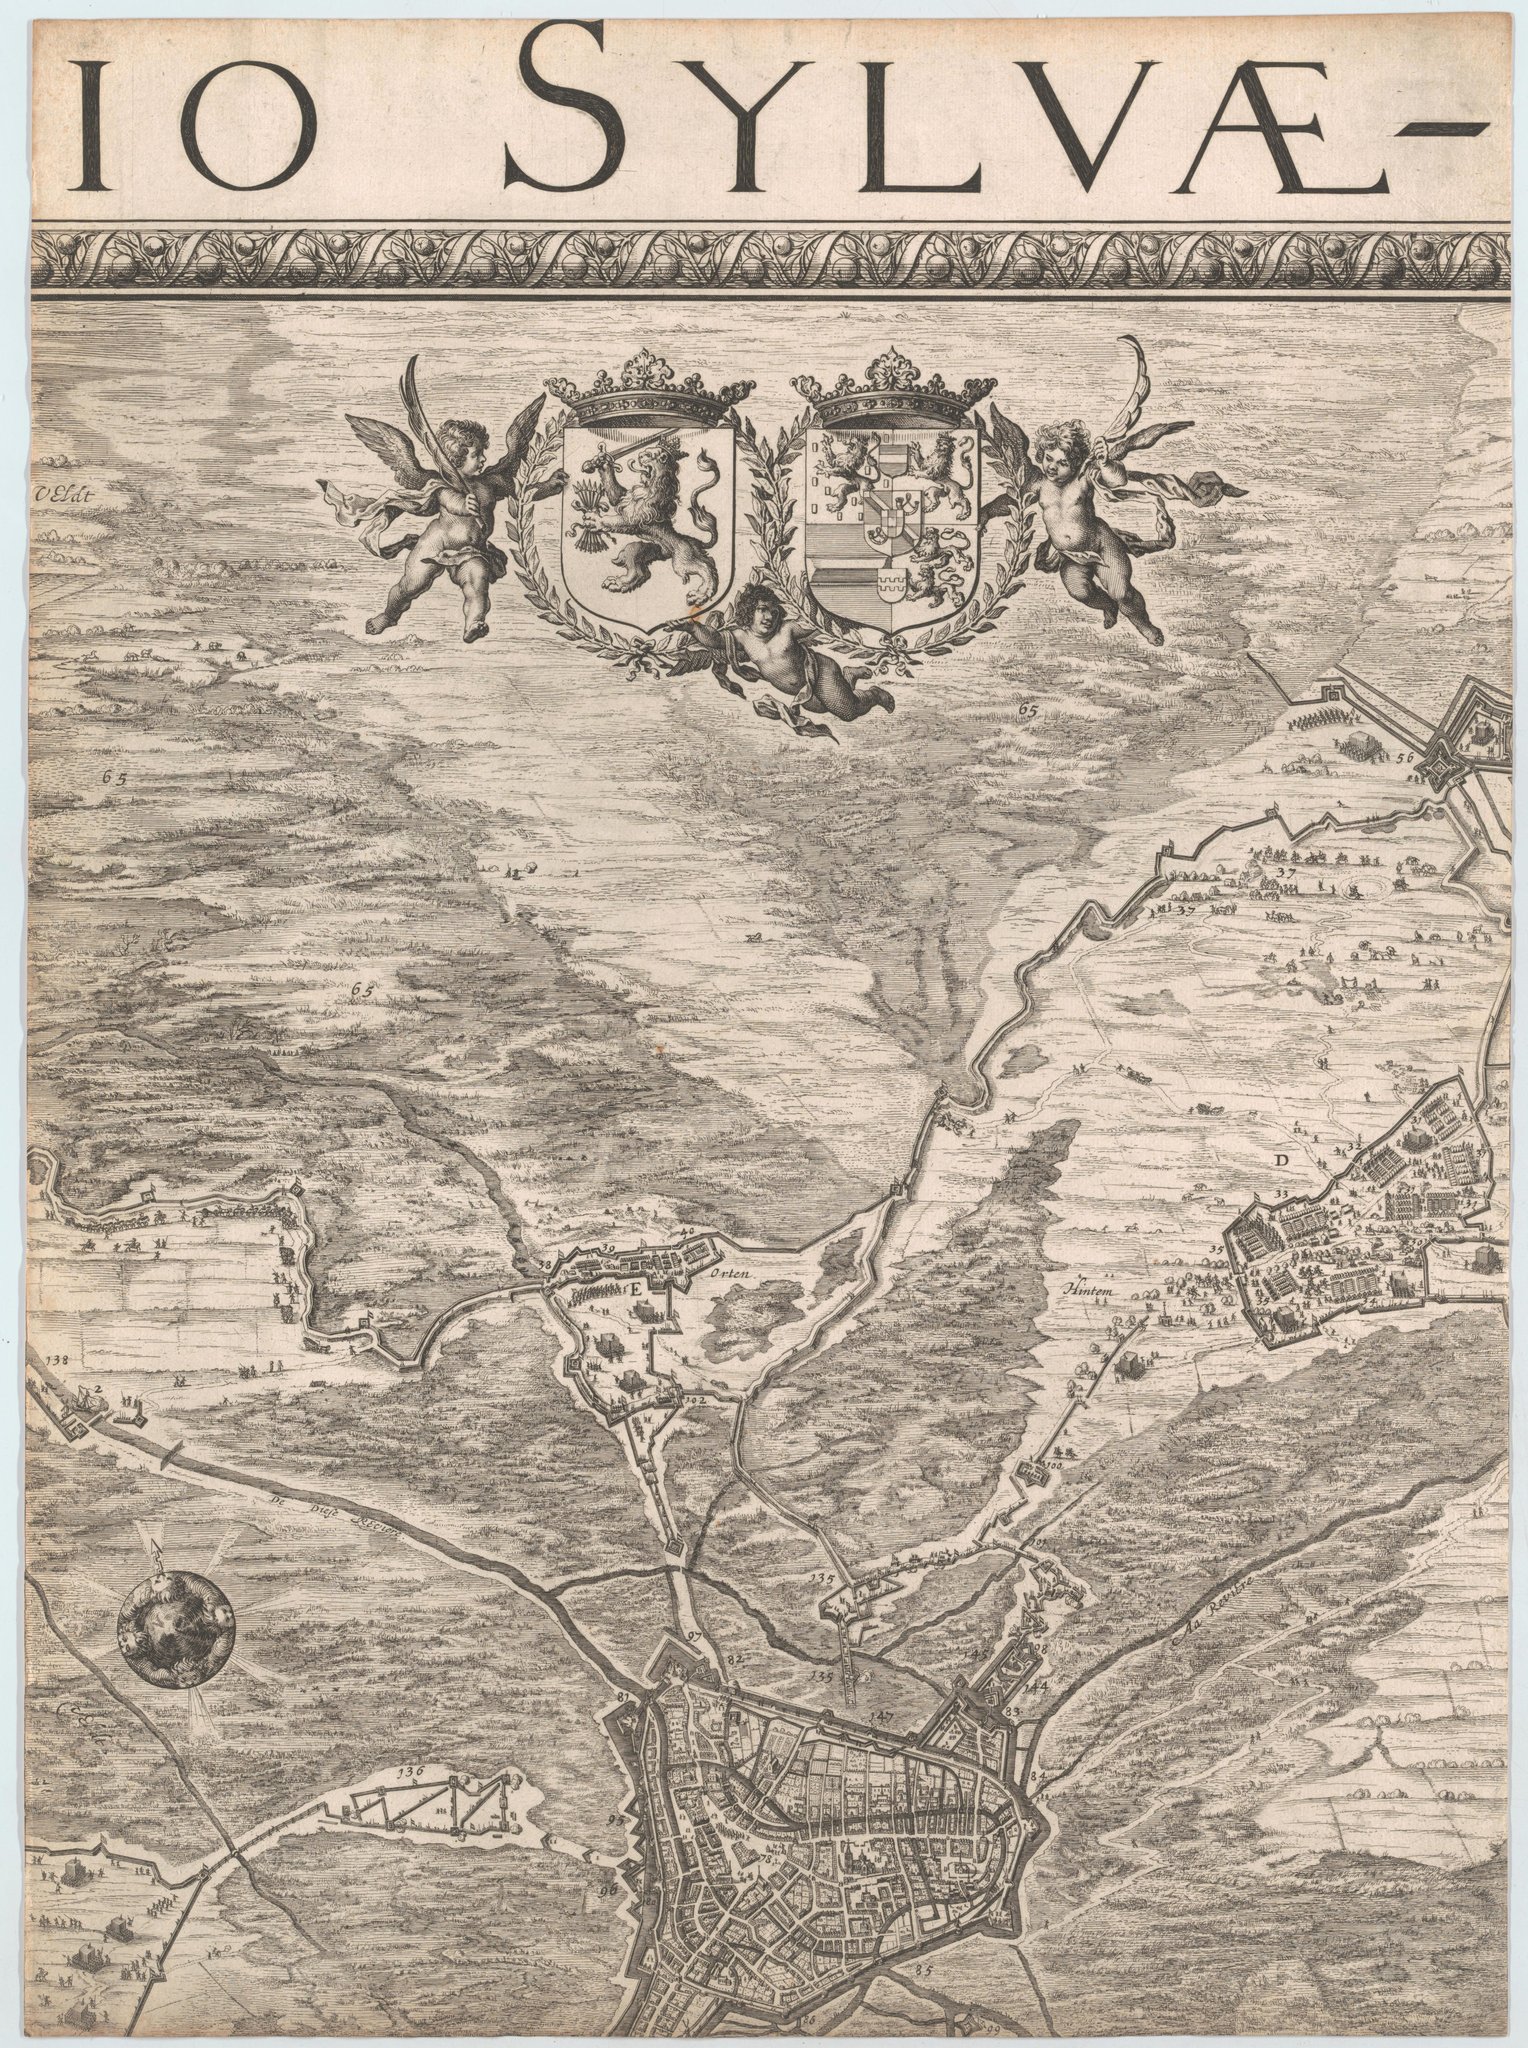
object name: print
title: Grote kaart van het beleg van Den Bosch door Frederik Hendrik (blad middenboven), 1629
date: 1629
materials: paper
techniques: etching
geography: the hague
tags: the hague, frederick henry (prince of orange), maps of separate countries or regions, siege, position war, den bosch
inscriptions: collector's mark: Lugt 1641, collector's mark: Lugt 963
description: Grote kaart van het beleg van Den Bosch door het Staatse leger onder Frederik Hendrik, van 1 mei tot 17 september 1629. Aan weerszijden van de kaart 18 kleine voorstellingen met details van de versterkingen van de stad en omliggende forten gemerkt I-Z. Kaart samengesteld uit zes platen en twee - ontbrekende - tekstbladen. Dit is het blad middenboven met een deel van de kaart met de stad zelf en de wapens van de Staten-Generaal en Frederik Hendrik. Onderwerpsrubrieken binnen de Atlas Zeden en Gewoonten: Krijgswezen, Verdedigingswerken.